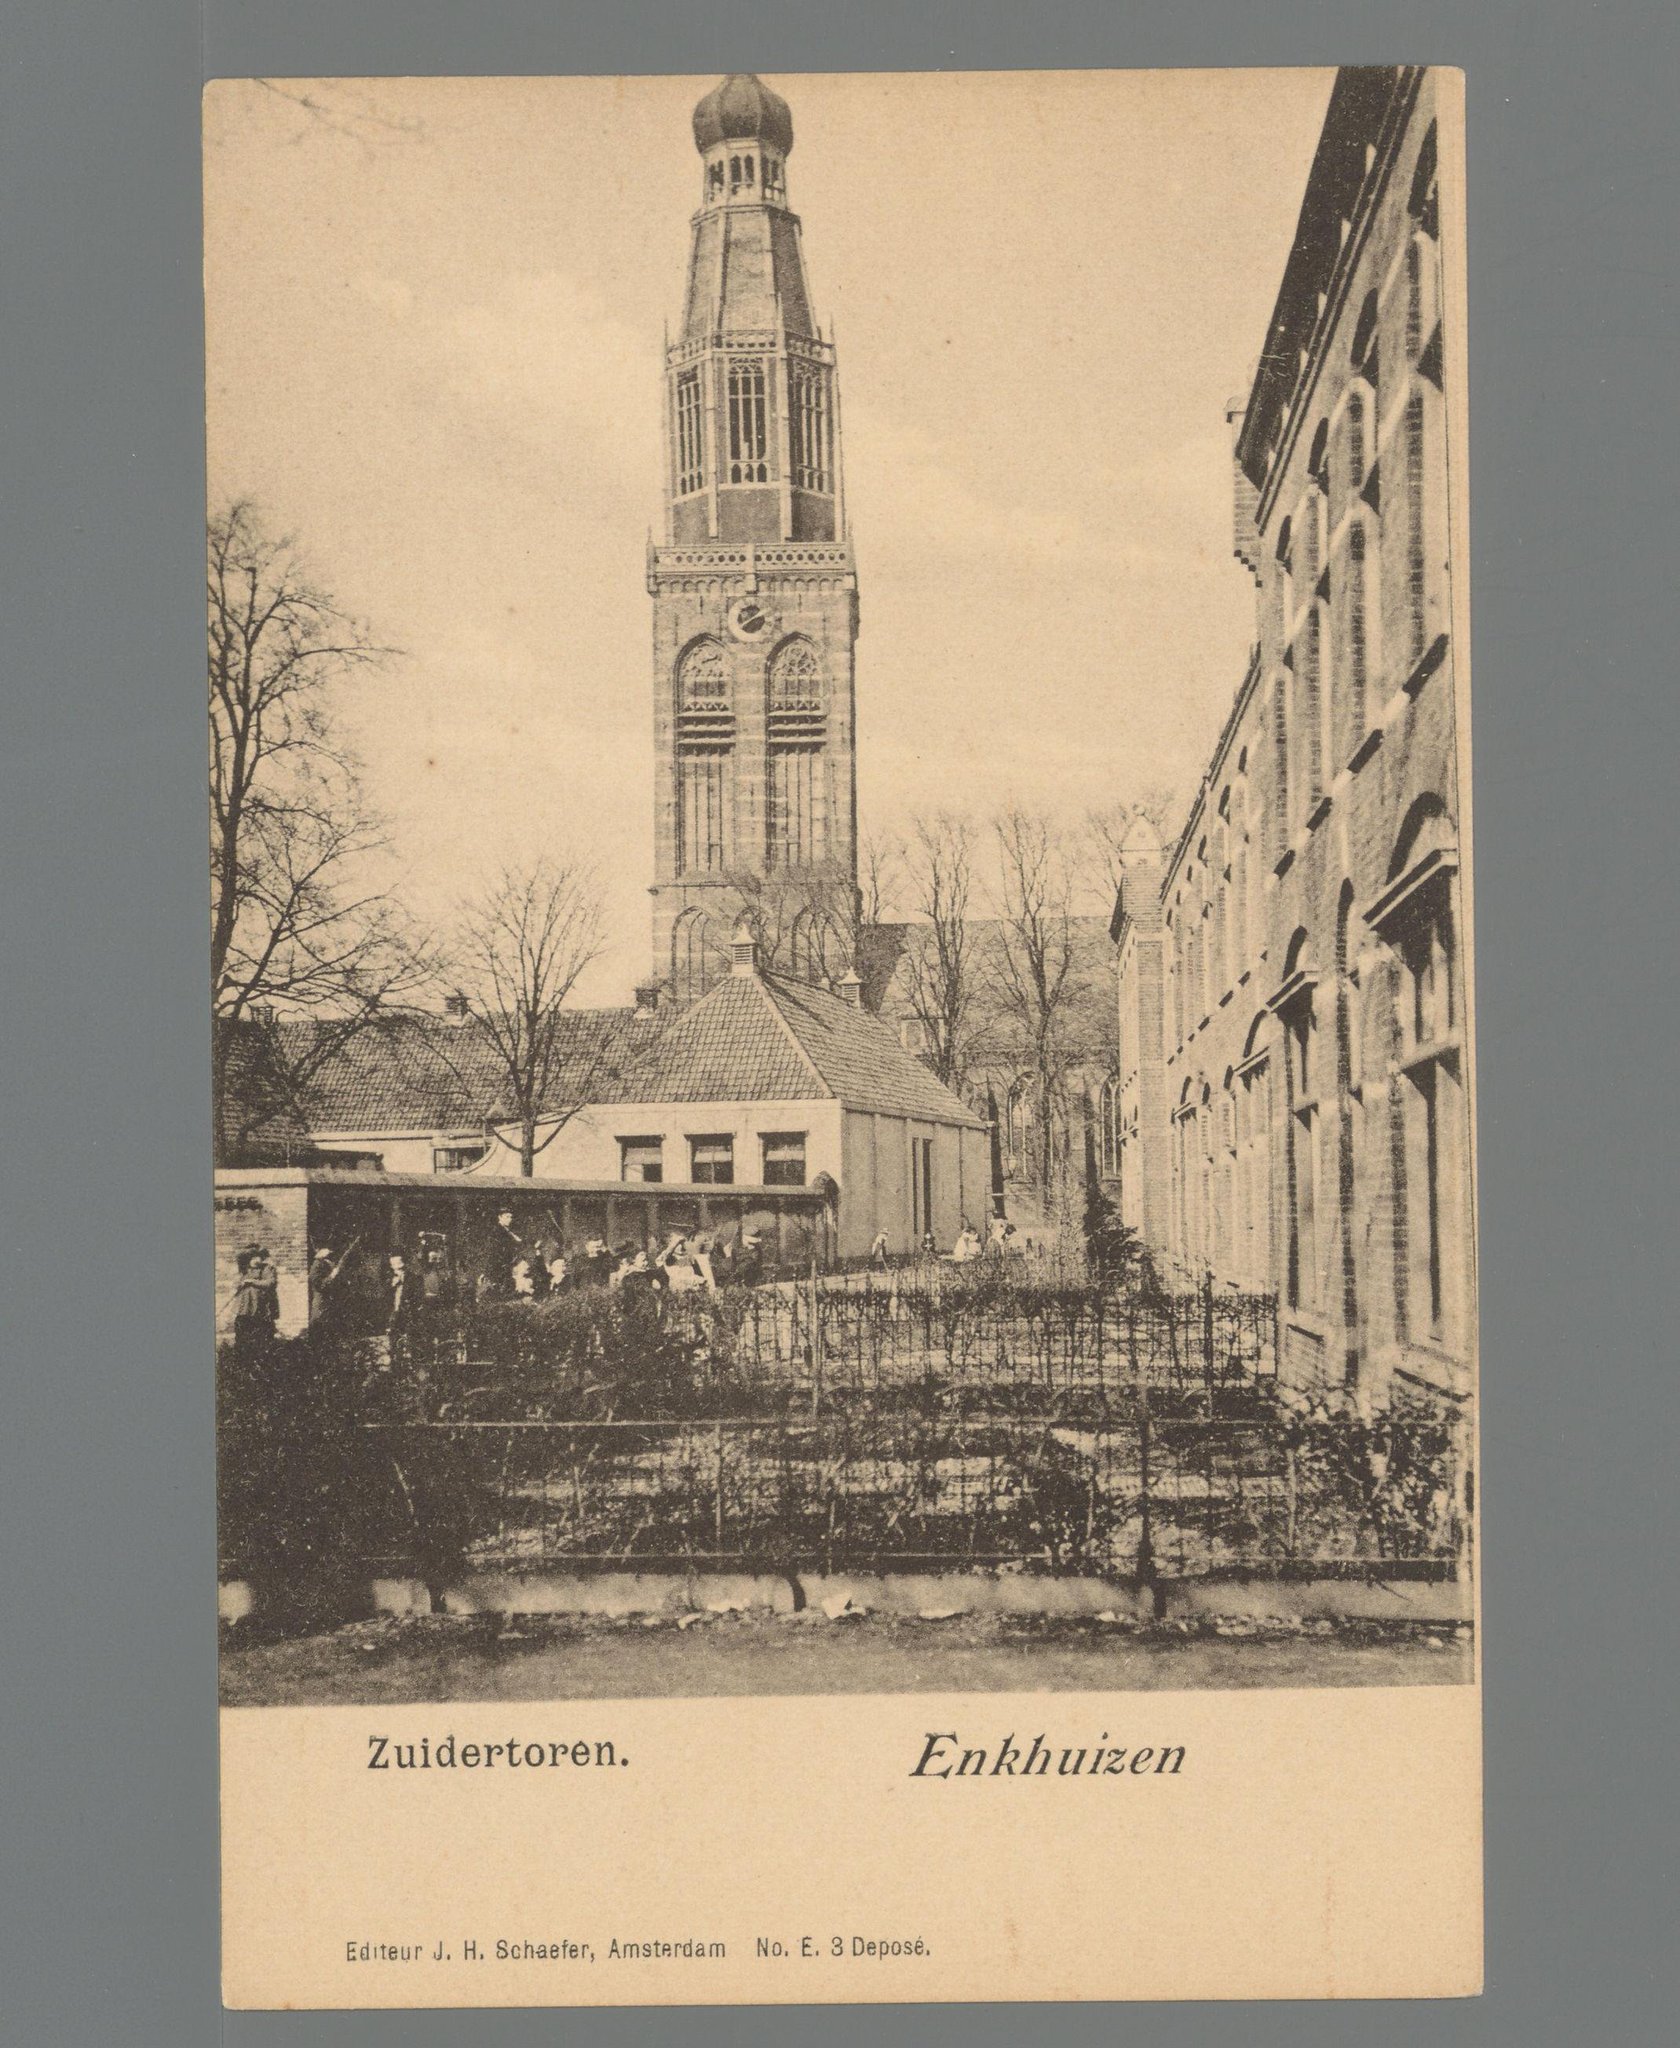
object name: ansichtkaart, prentbriefkaart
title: Zuidertoren. Enkhuizen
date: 1892-1905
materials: cardboard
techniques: photograph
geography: enkhuizen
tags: city-view, and landscape with man-made constructions, parts of church exterior and annexes: tower, enkhuizen